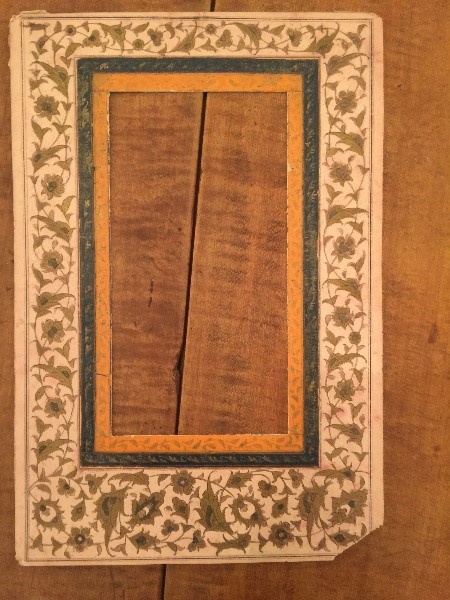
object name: folio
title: Decorated Folio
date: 1501-1800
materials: gold, ink, paper, watercolor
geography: iran